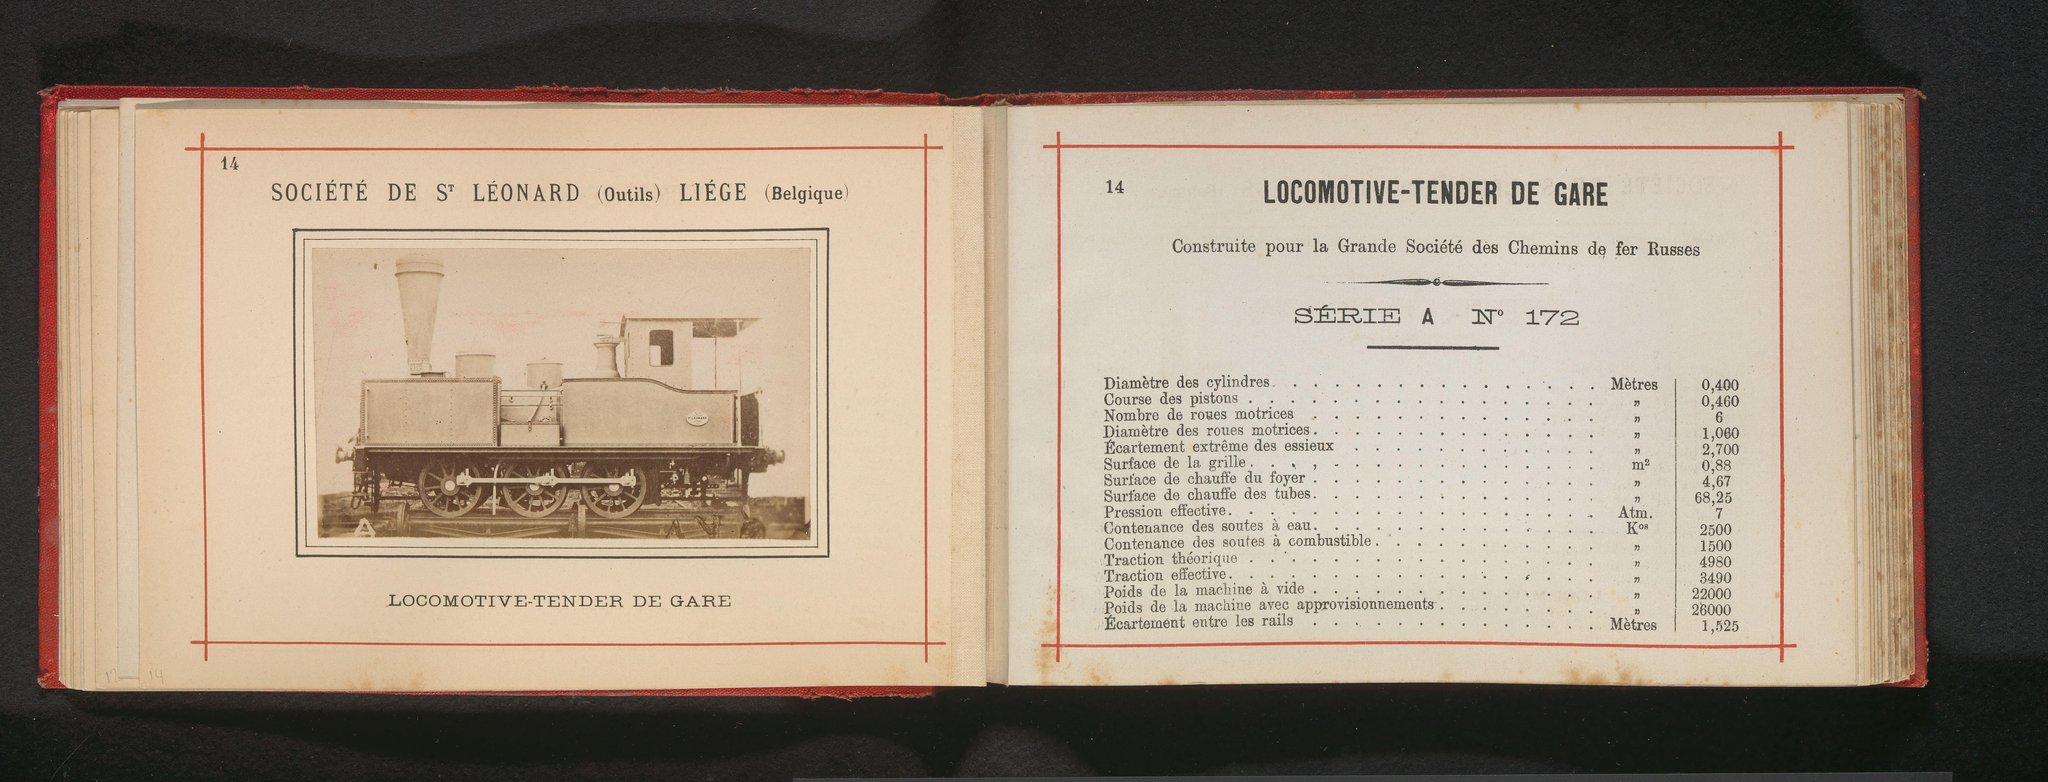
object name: photograph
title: Locomotive-tender de gare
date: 1880-1885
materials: photographic support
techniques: albumen print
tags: locomotive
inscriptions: inscription: ‘Société de St. Léonard (Outils) Liége (Belgique)’